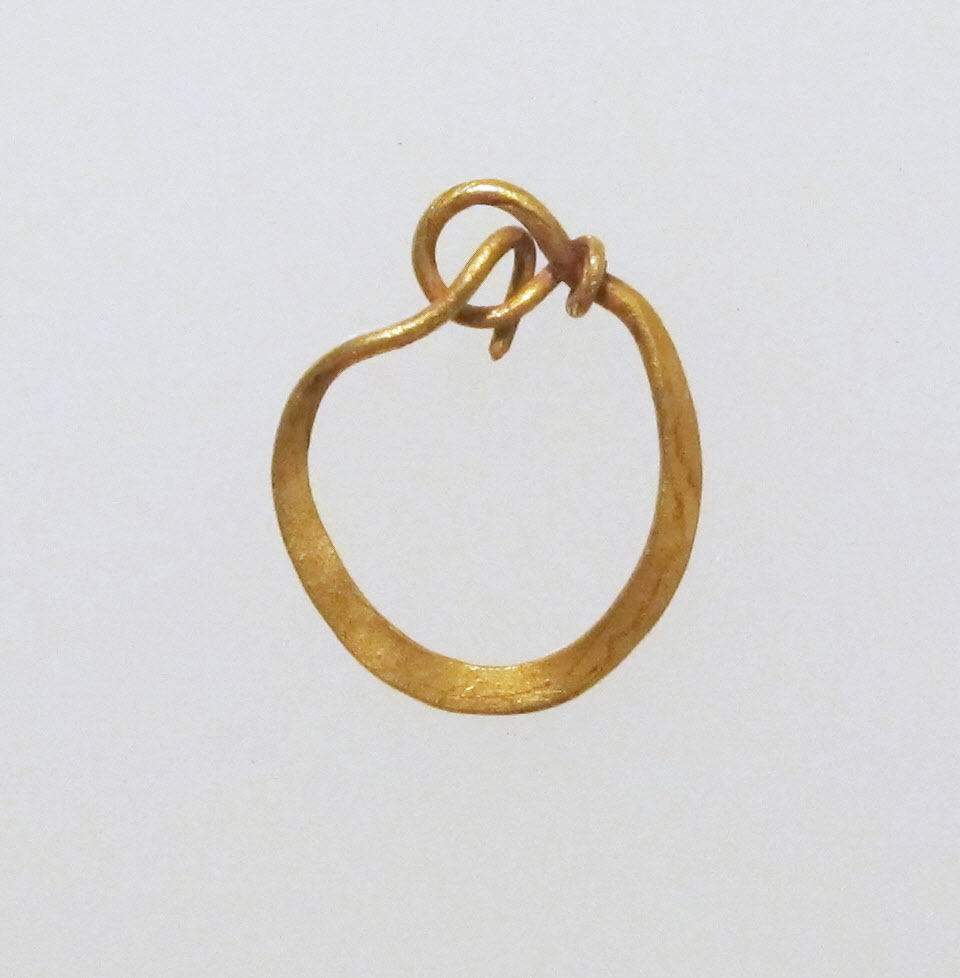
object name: earring loop type, hammered flat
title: Earring-loop type, hammered flat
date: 7000 BCE-330 CE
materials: gold